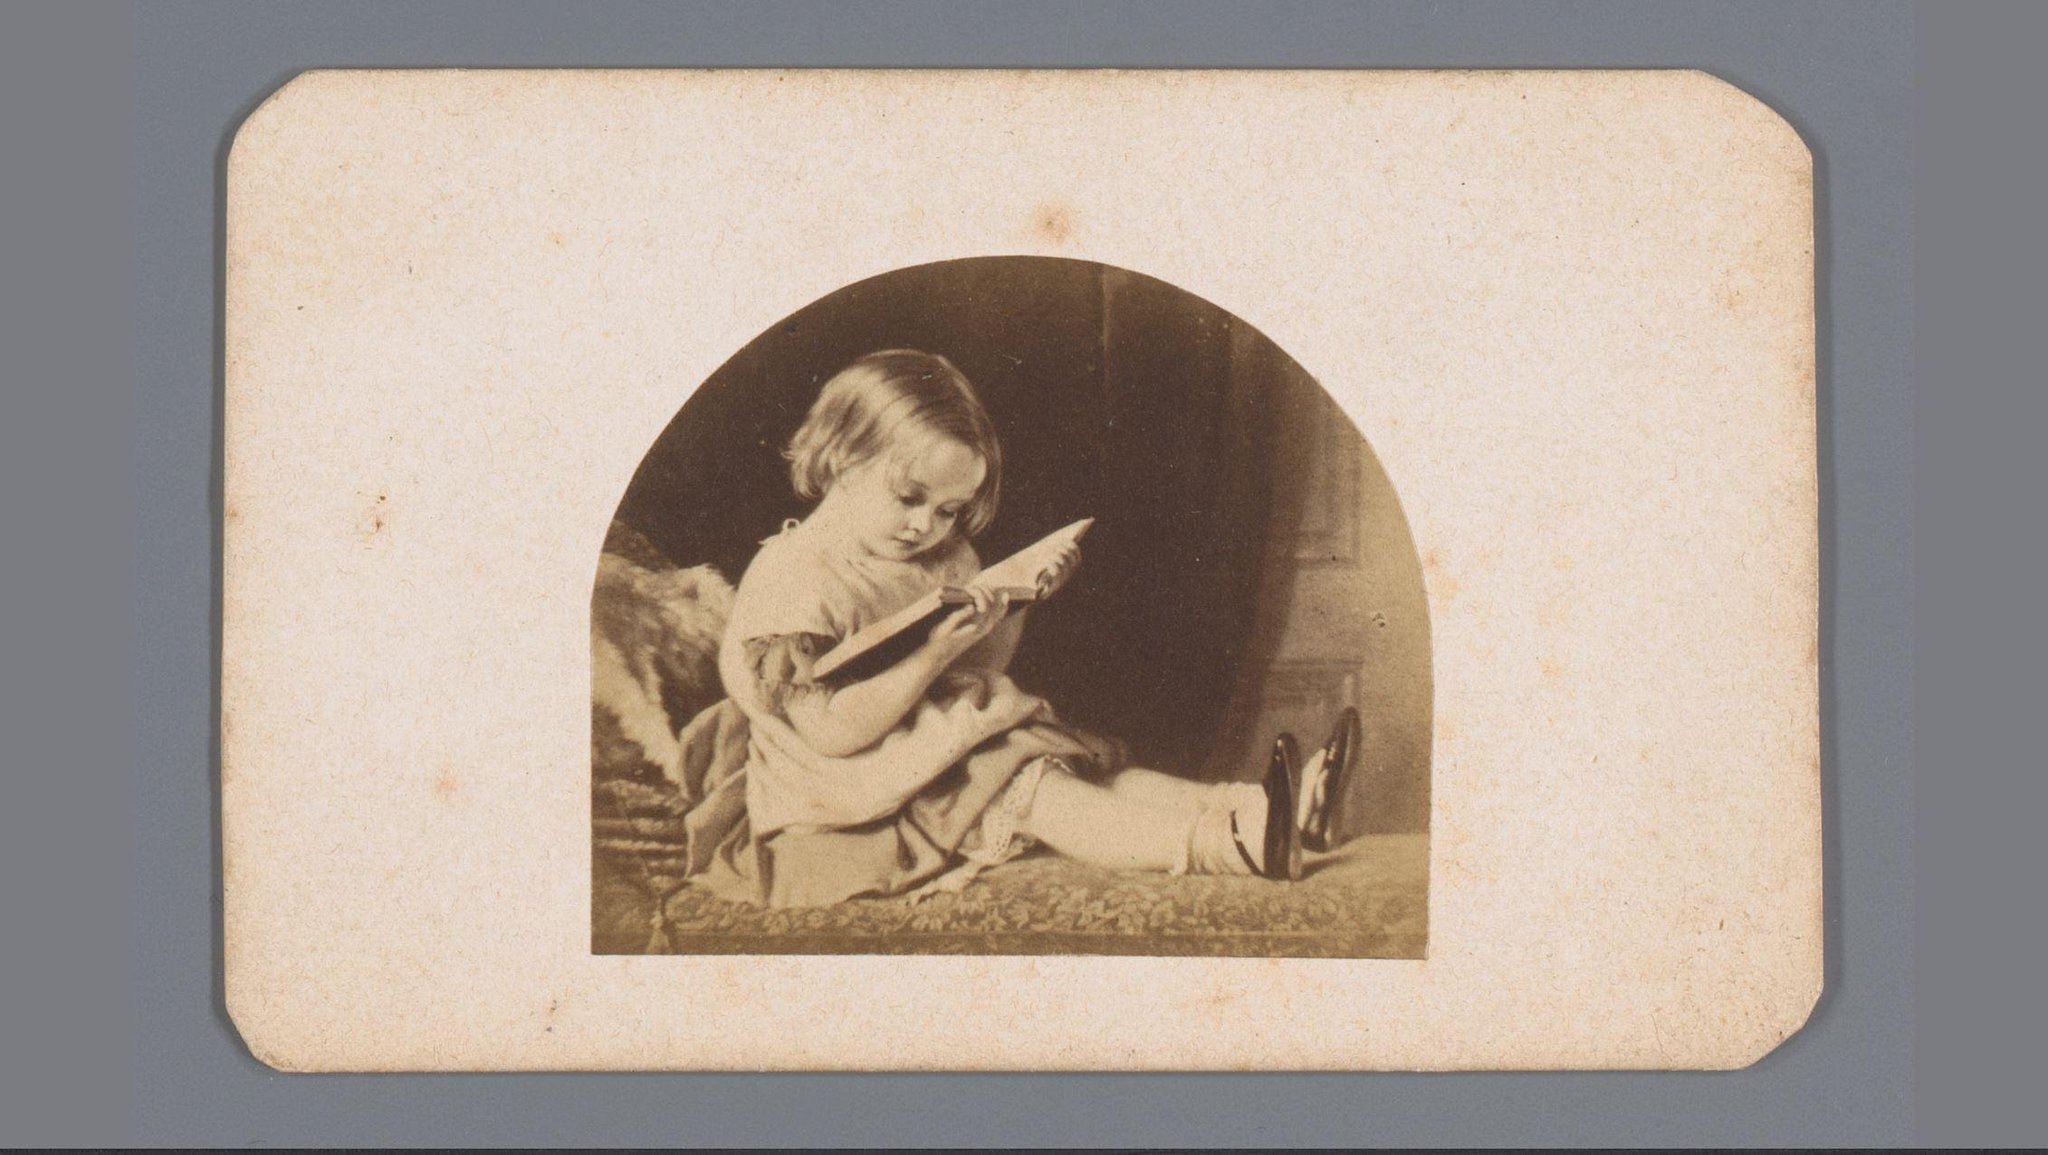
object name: photograph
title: Fotoreproductie van een schilderij van een lezend meisje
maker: Anonymous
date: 1855-1885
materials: cardboard, paper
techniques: albumen print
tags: reading, girl (child between toddler and youth)